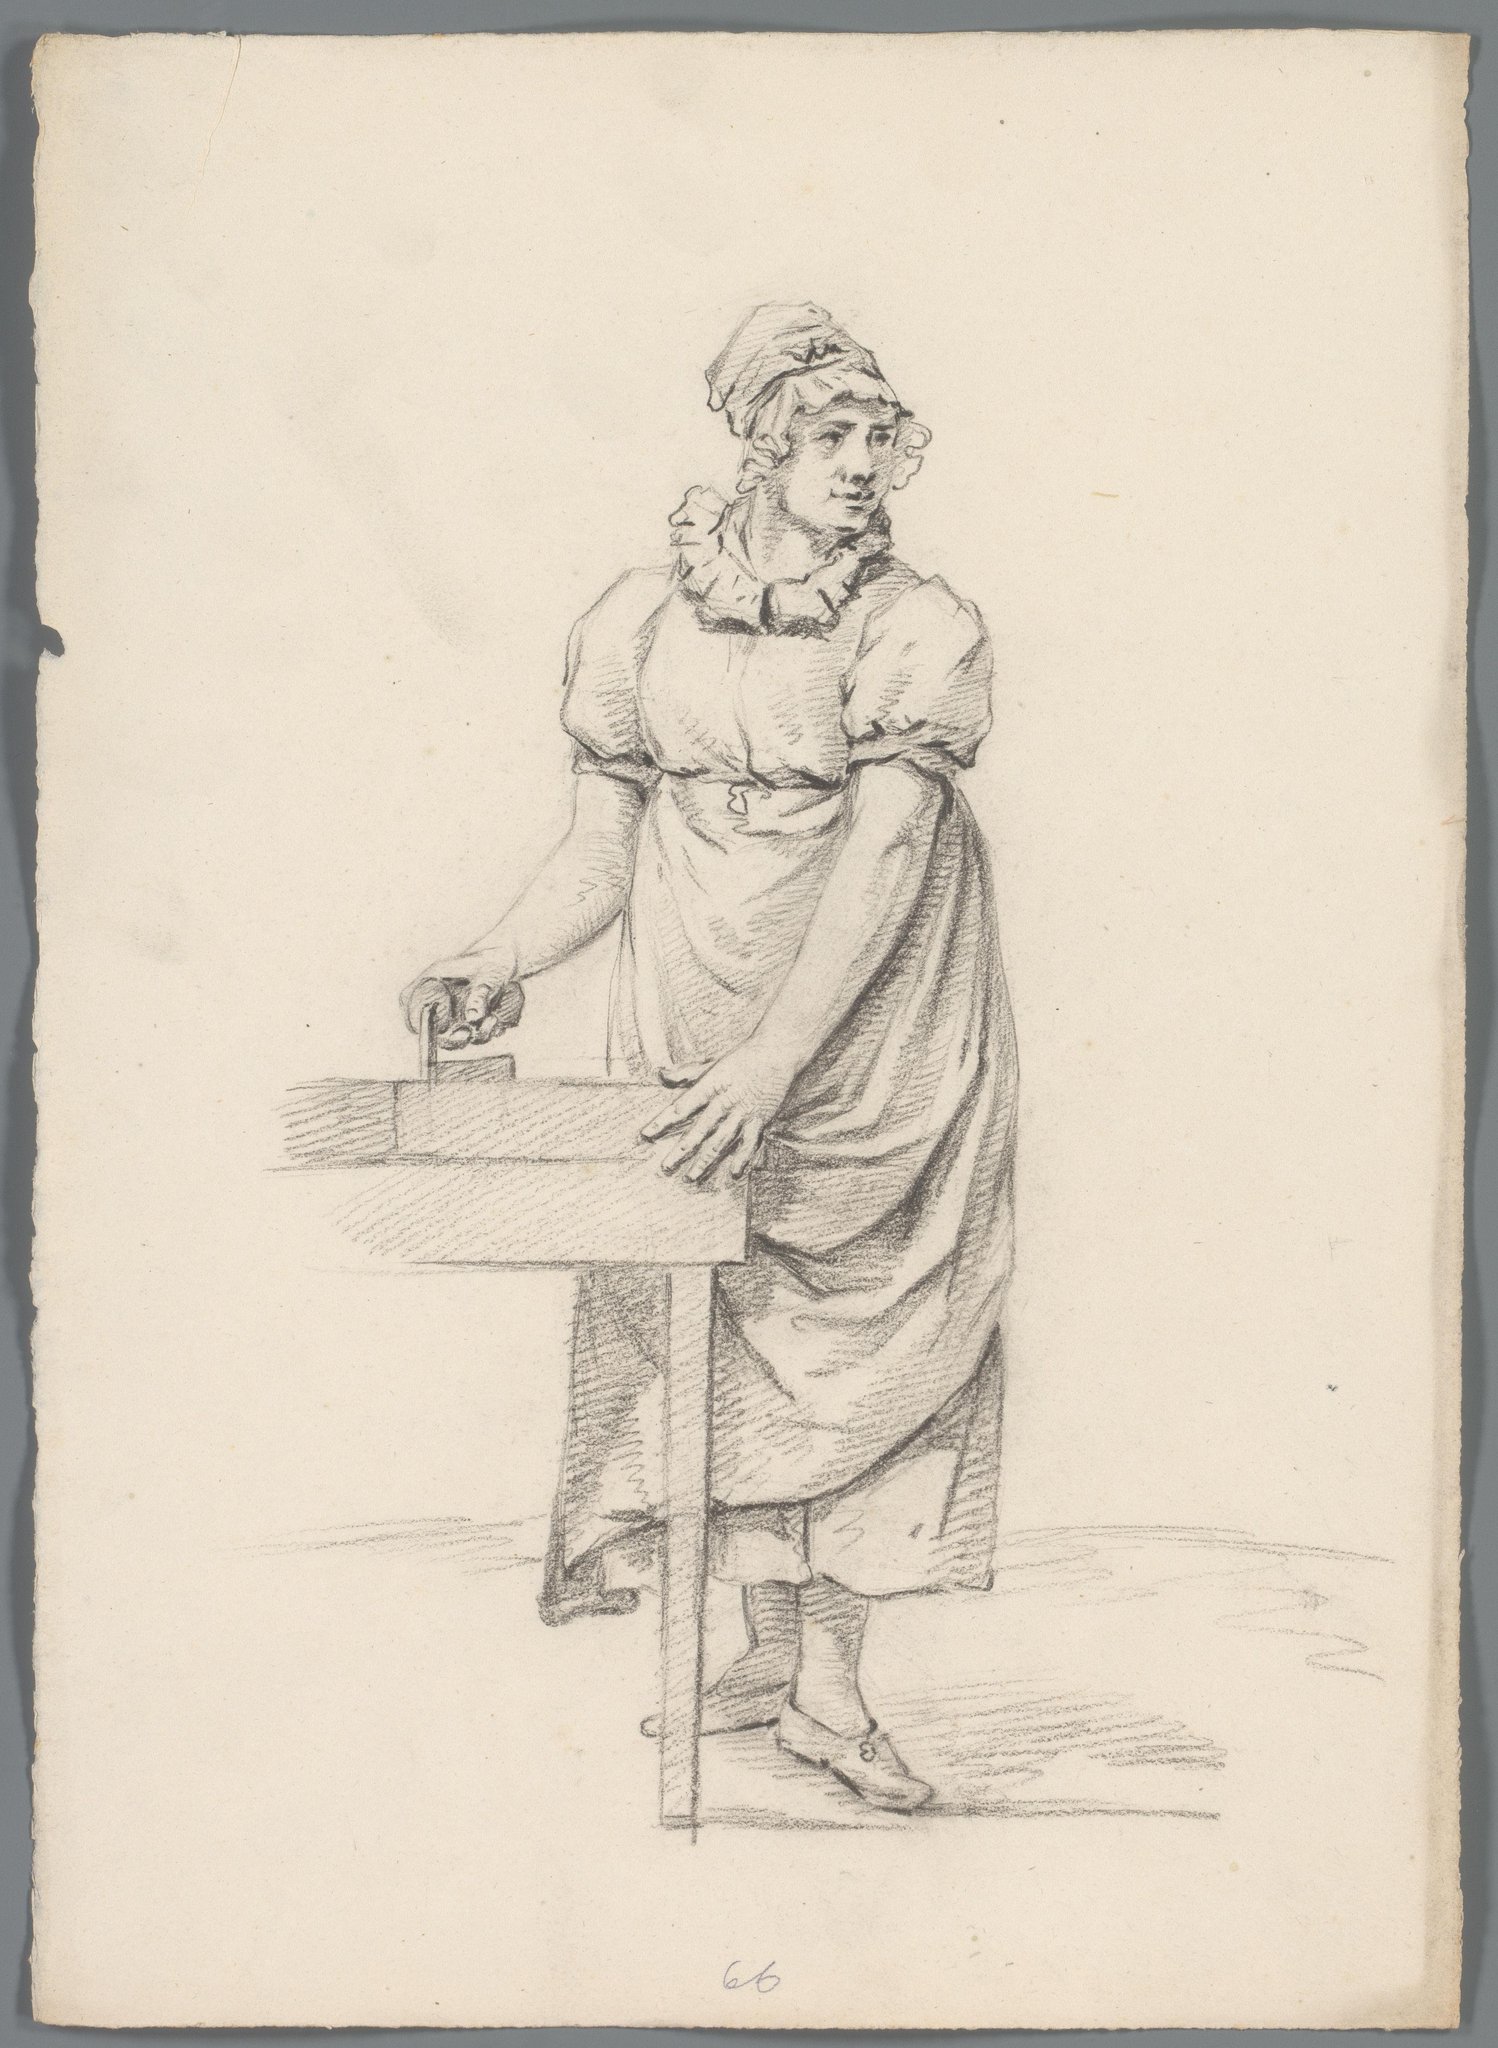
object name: drawing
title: Strijkende vrouw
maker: Anonymous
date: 1820-1830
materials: chalk, paper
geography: the hague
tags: ironing, adult woman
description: Tekeningen waarschijnlijk ontstaan bij het Haagse kunstgenootschap ‘Tot Nut der Tekenkunst’, waar twee keer per week tekenavonden werden georganiseerd met geklede modellen.